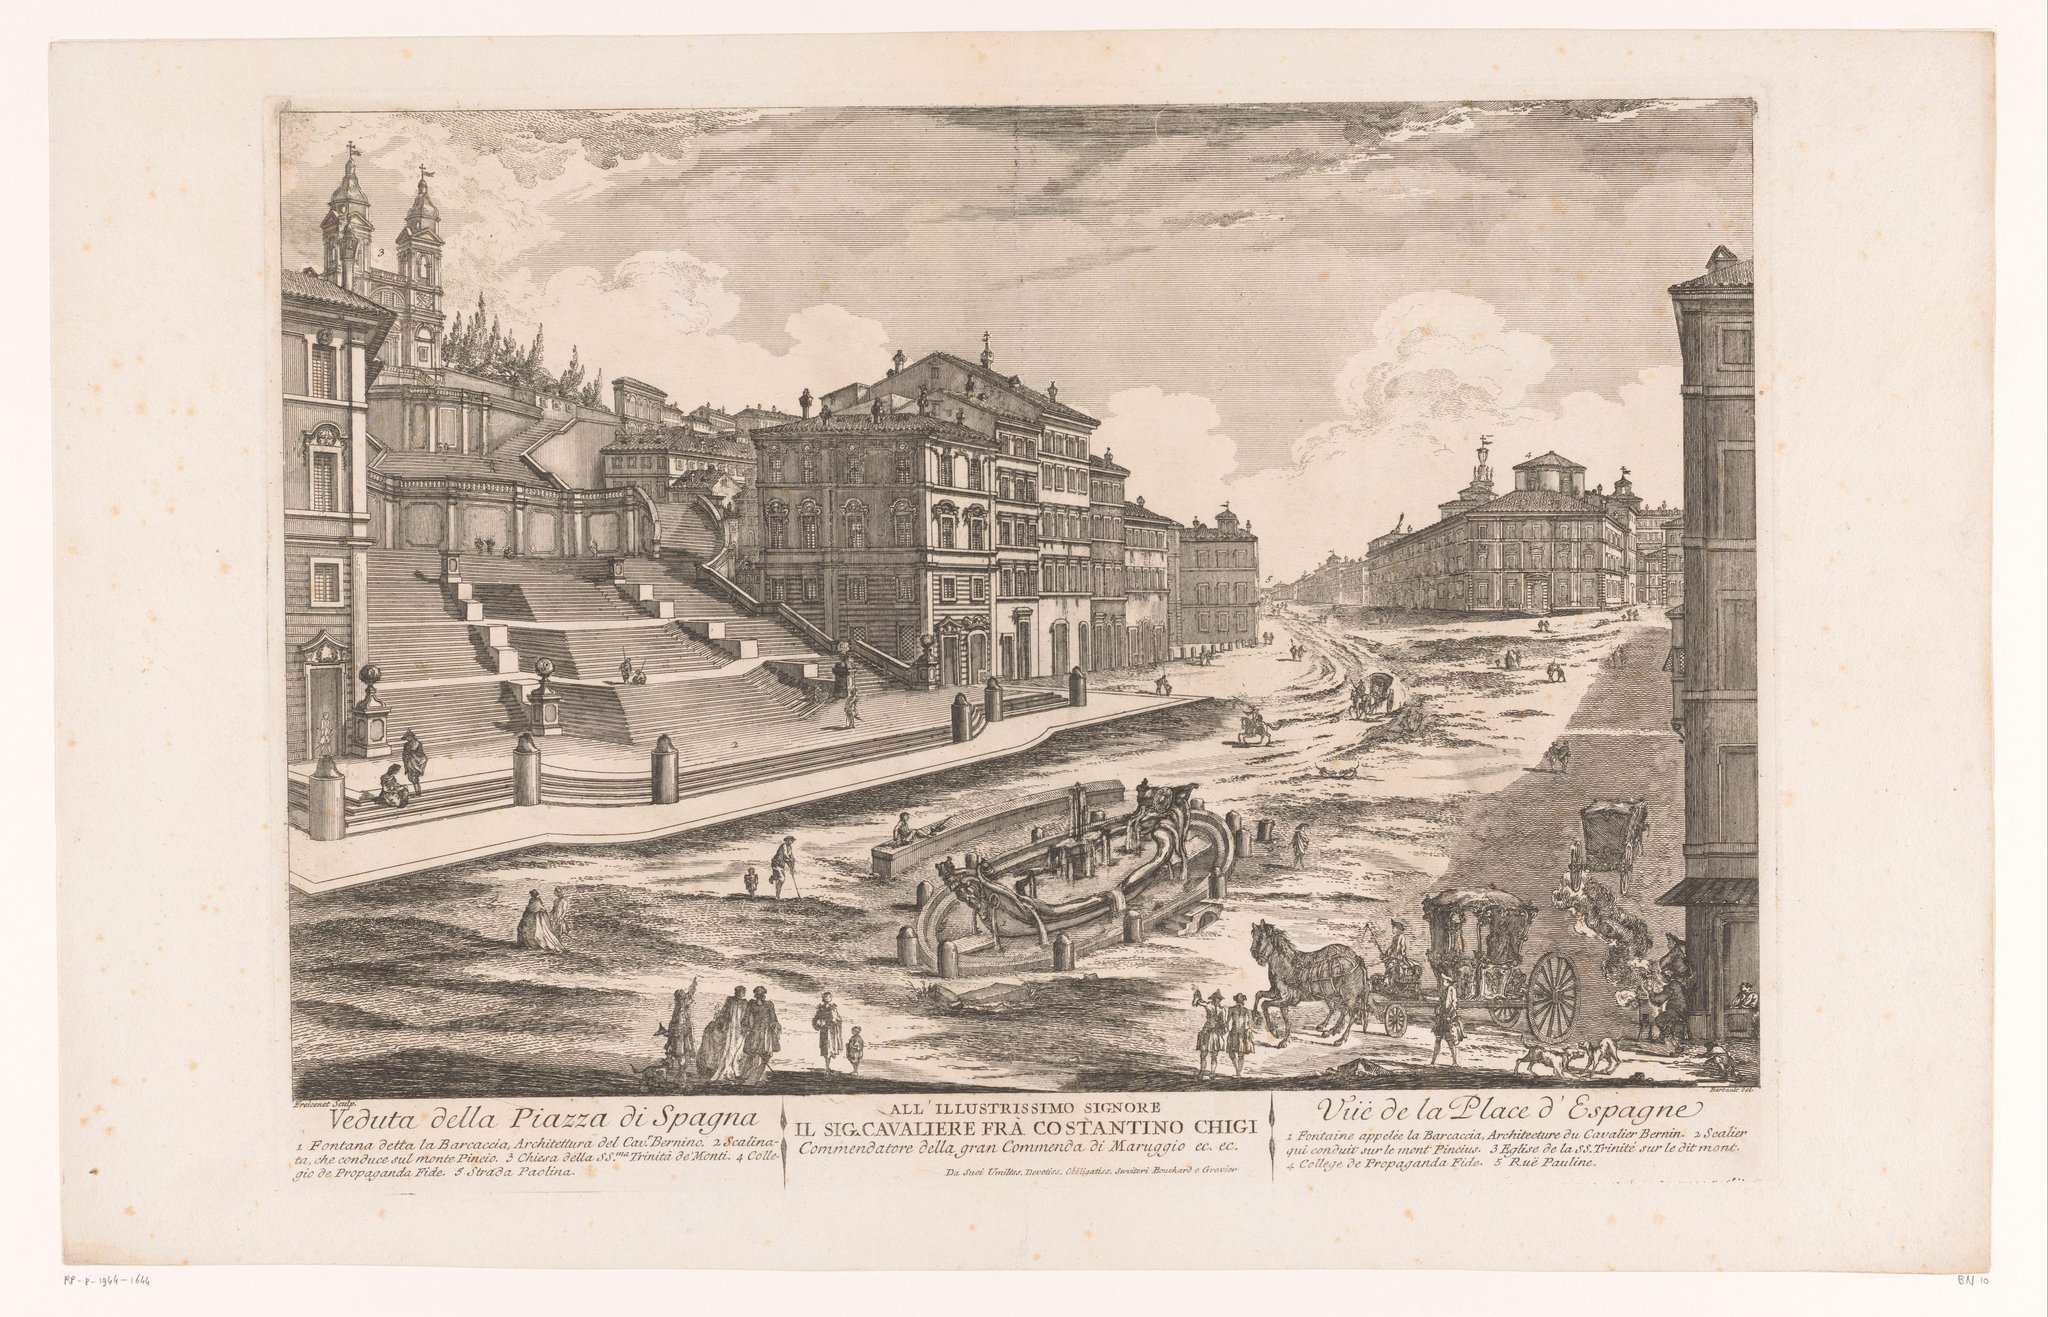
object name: book illustration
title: Gezicht op het Piazza di Spagna te Rome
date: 1763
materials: paper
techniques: etching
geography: rome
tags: square, place, circus, etc., city-view in general; 'veduta'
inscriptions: collector's mark: Lugt 2228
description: Prent gebruikt voor: Barbault, Jean. Les plus beaux édifices de Rome moderne publiés par Jean Barbault peintre (...). Rome: Bouchard et Gravier, 1763.